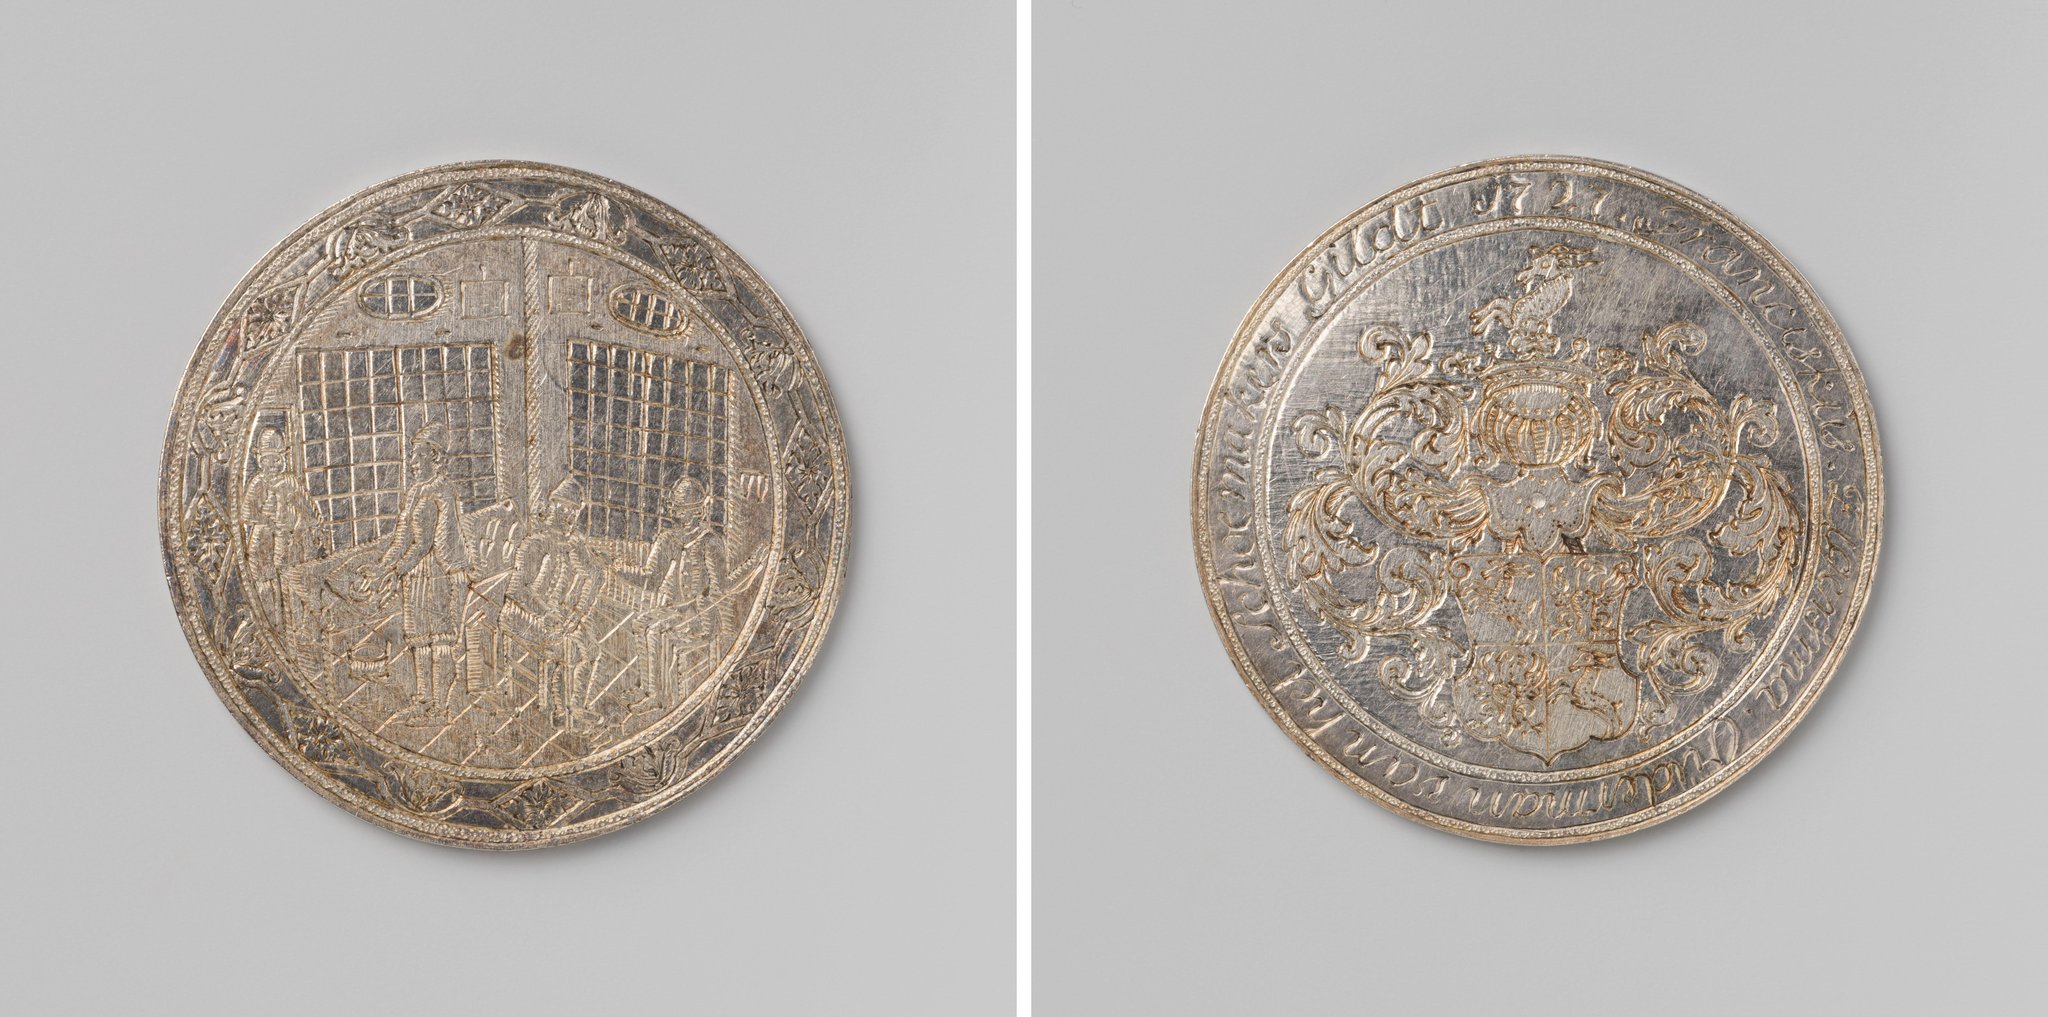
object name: medal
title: Schoenmakersgilde van Bolsward, overmanspenning van burgemeester Franciscus Elgersma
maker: Anonymous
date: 1727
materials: silver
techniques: engraving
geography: netherlands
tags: mayor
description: Guilds were urban organisations of people in specific occupations. The guild represented the interests of the profession. Each member had a token as proof of membership. The person’s name was engraved on one side of the token, often together with the arms of the guild or of the city in which it was based. The other side carried a motif signifying the occupation represented by the guild.